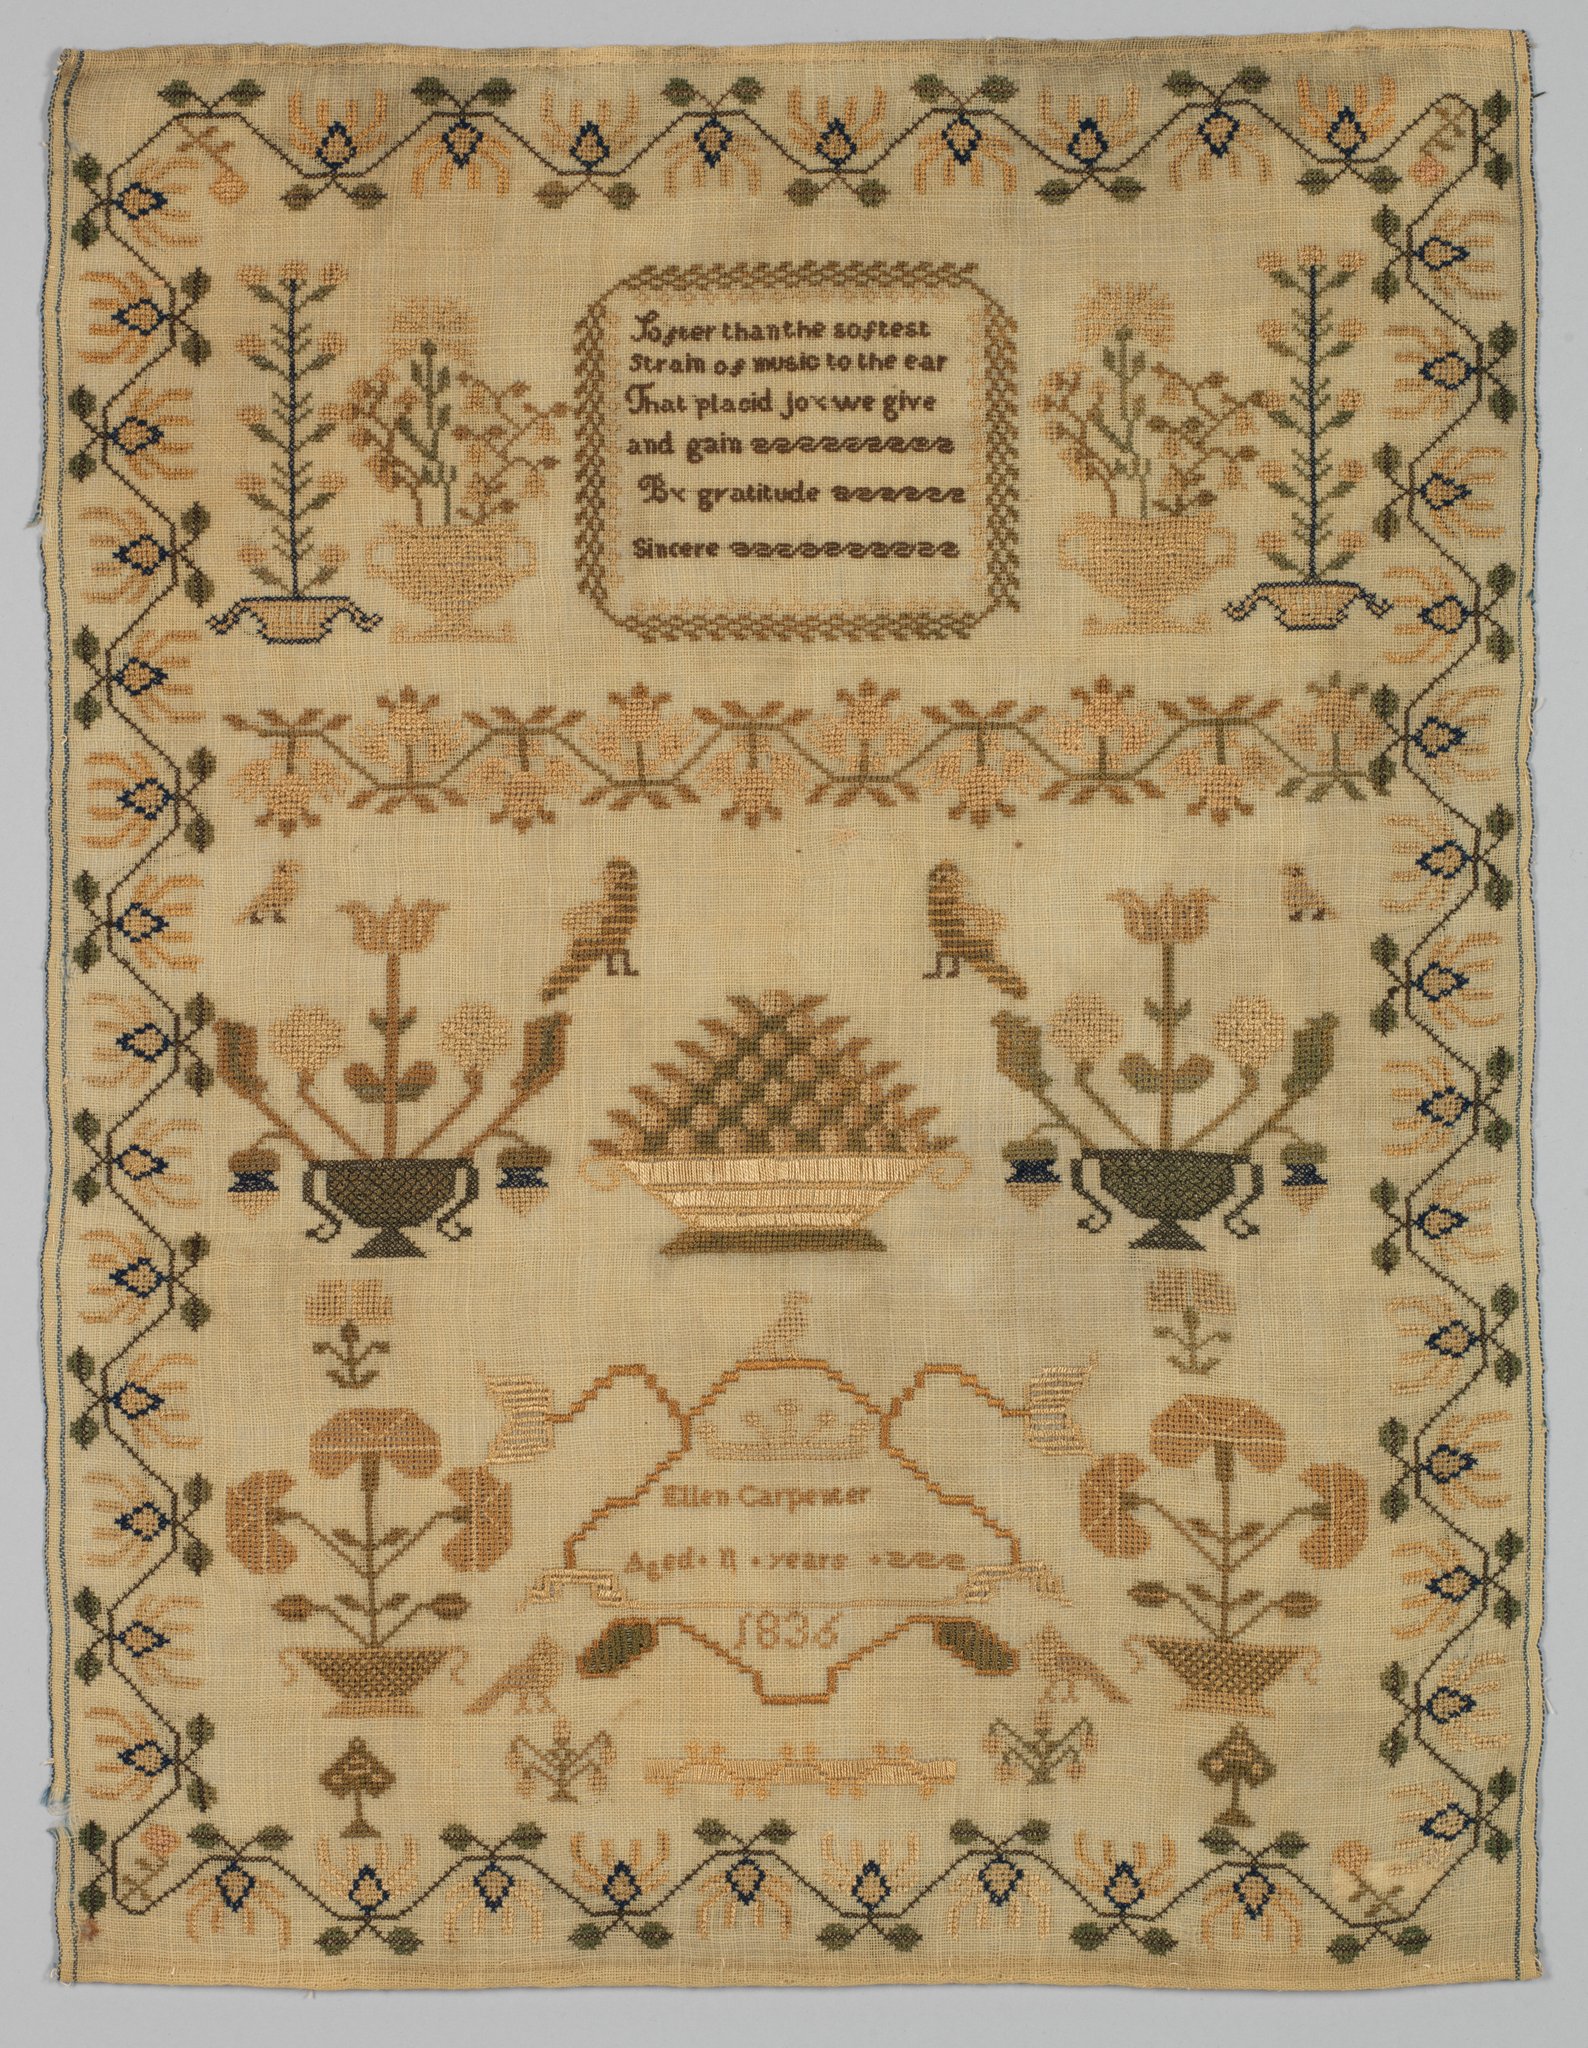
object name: sampler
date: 1836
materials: canvas, silk, wool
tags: birds,flowers